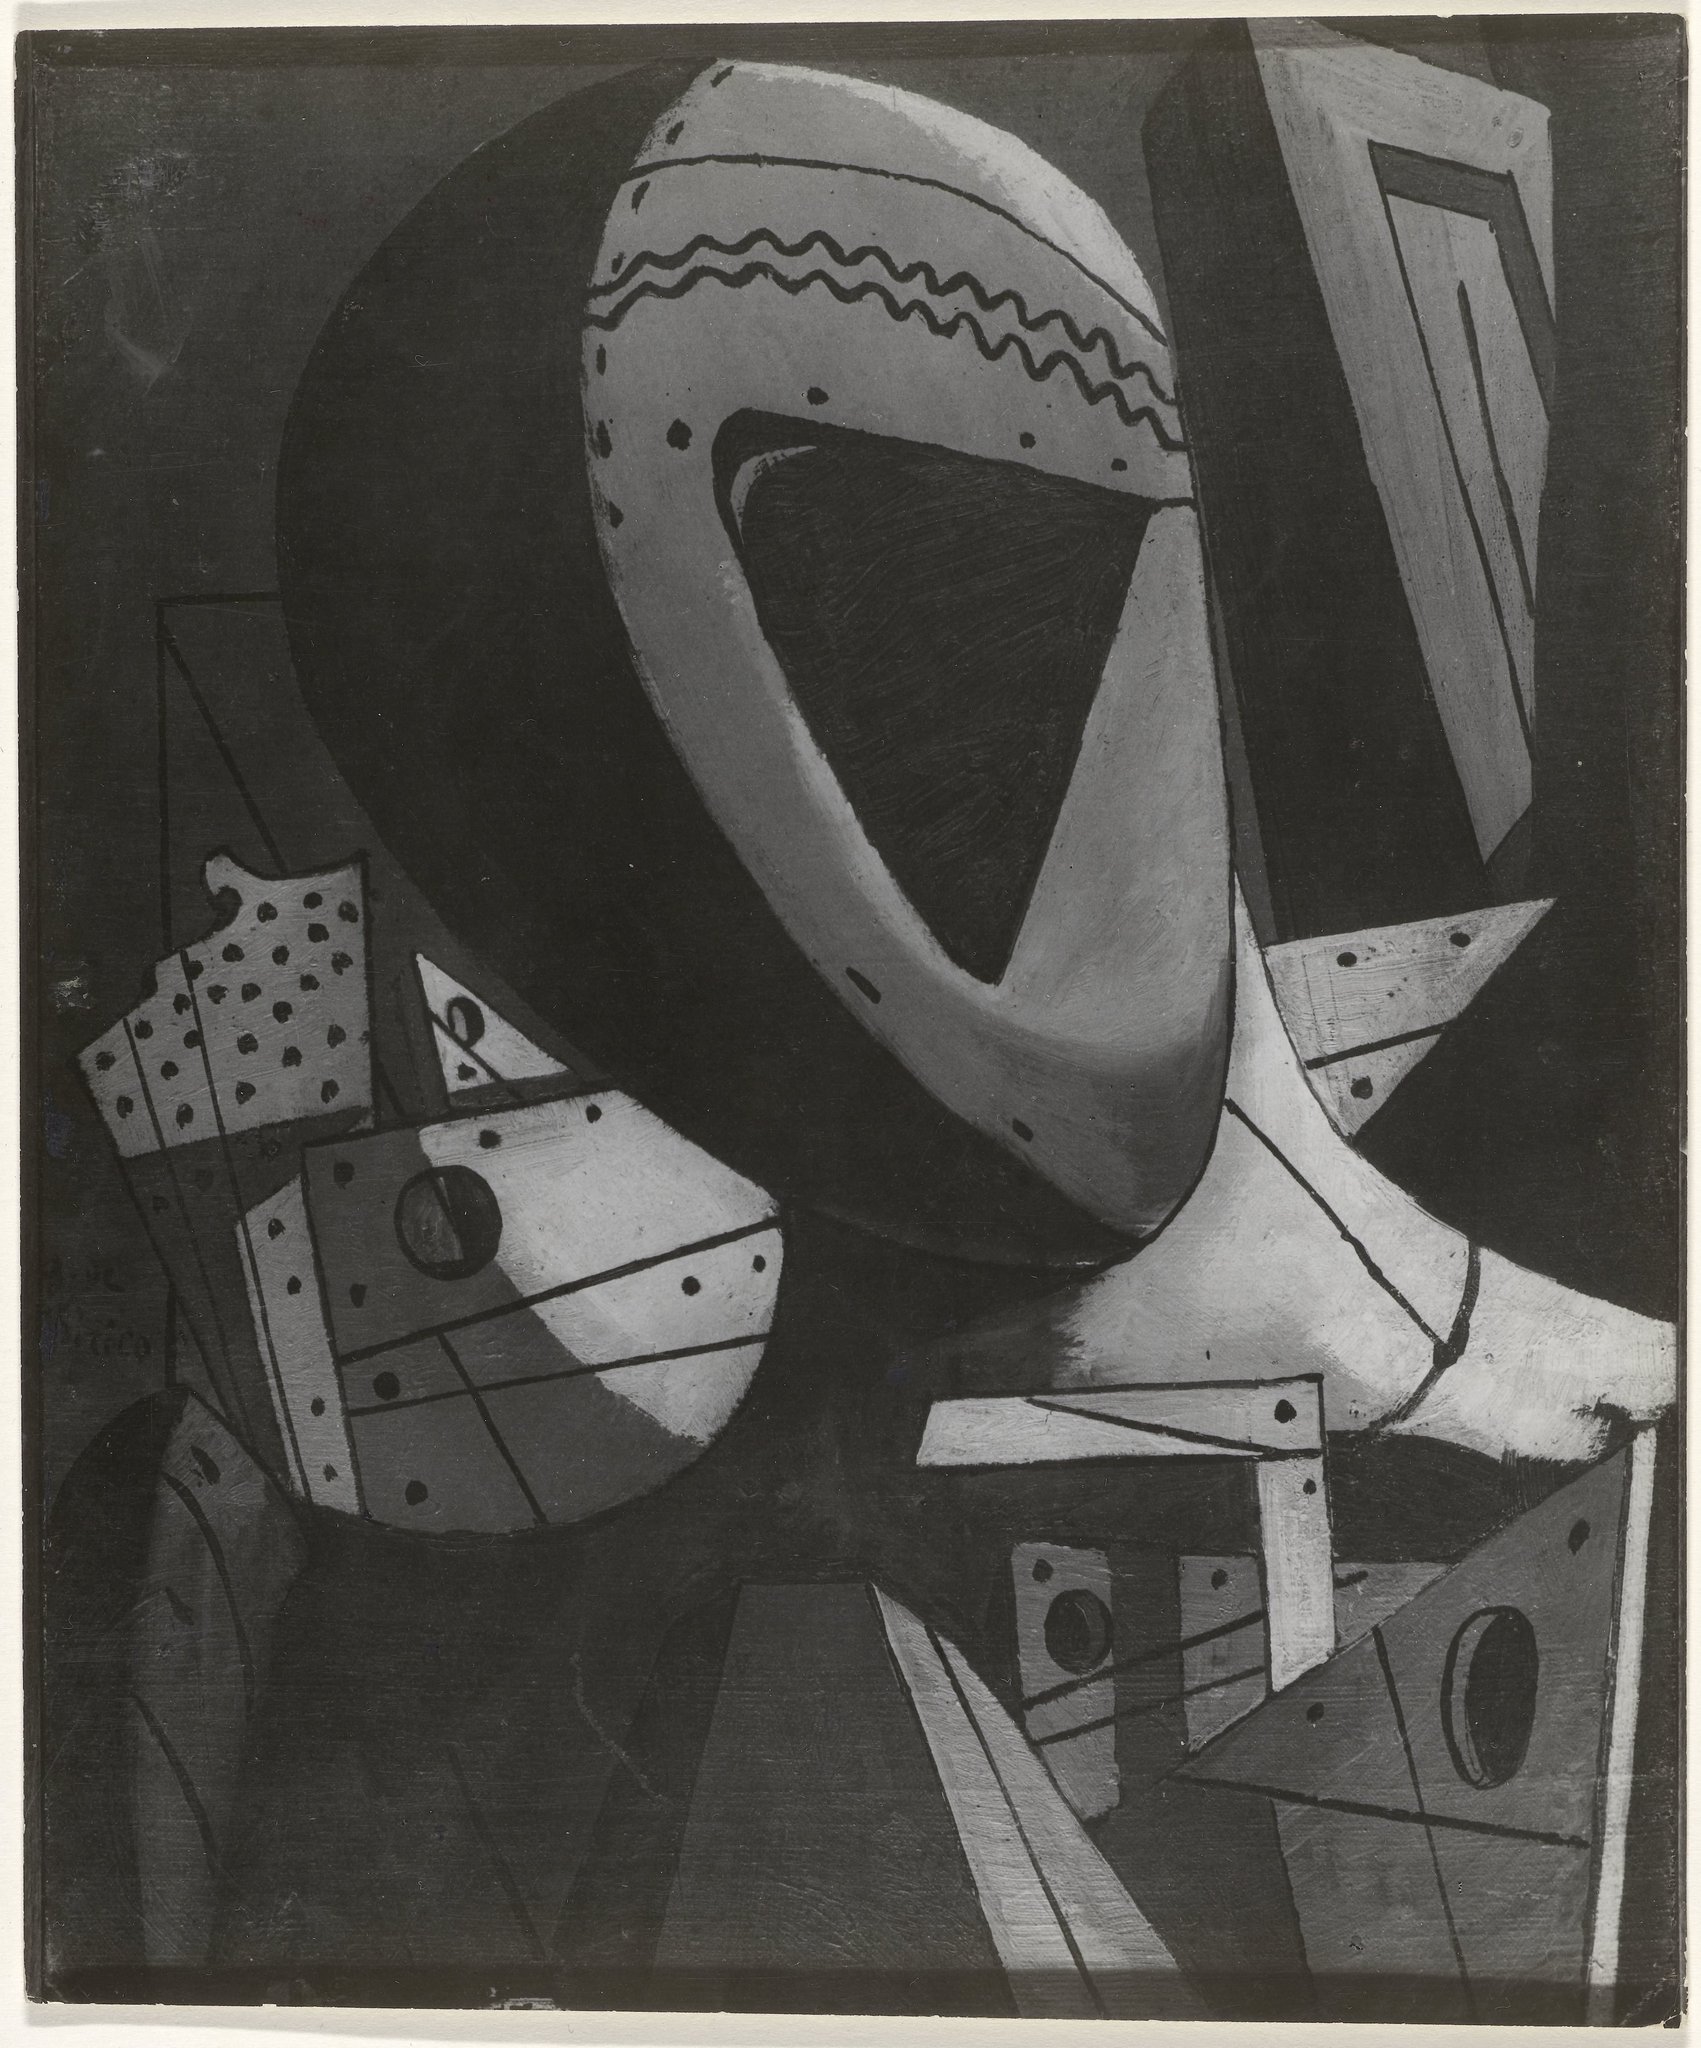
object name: photograph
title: Reproductie schilderij Muse deconcertee van De Chirico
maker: lilly samuel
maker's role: fotograaf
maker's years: 1909-1944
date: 1938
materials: photographic support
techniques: gelatin silver print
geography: amsterdam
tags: amsterdam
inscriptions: stamp: ‘galerie Robert Keizersgracht 527’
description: Onderdeel van een serie betreffende een reizende tentoonstelling "Exposition Internationale du Surréalisme", in galerie Robert te Amsterdam